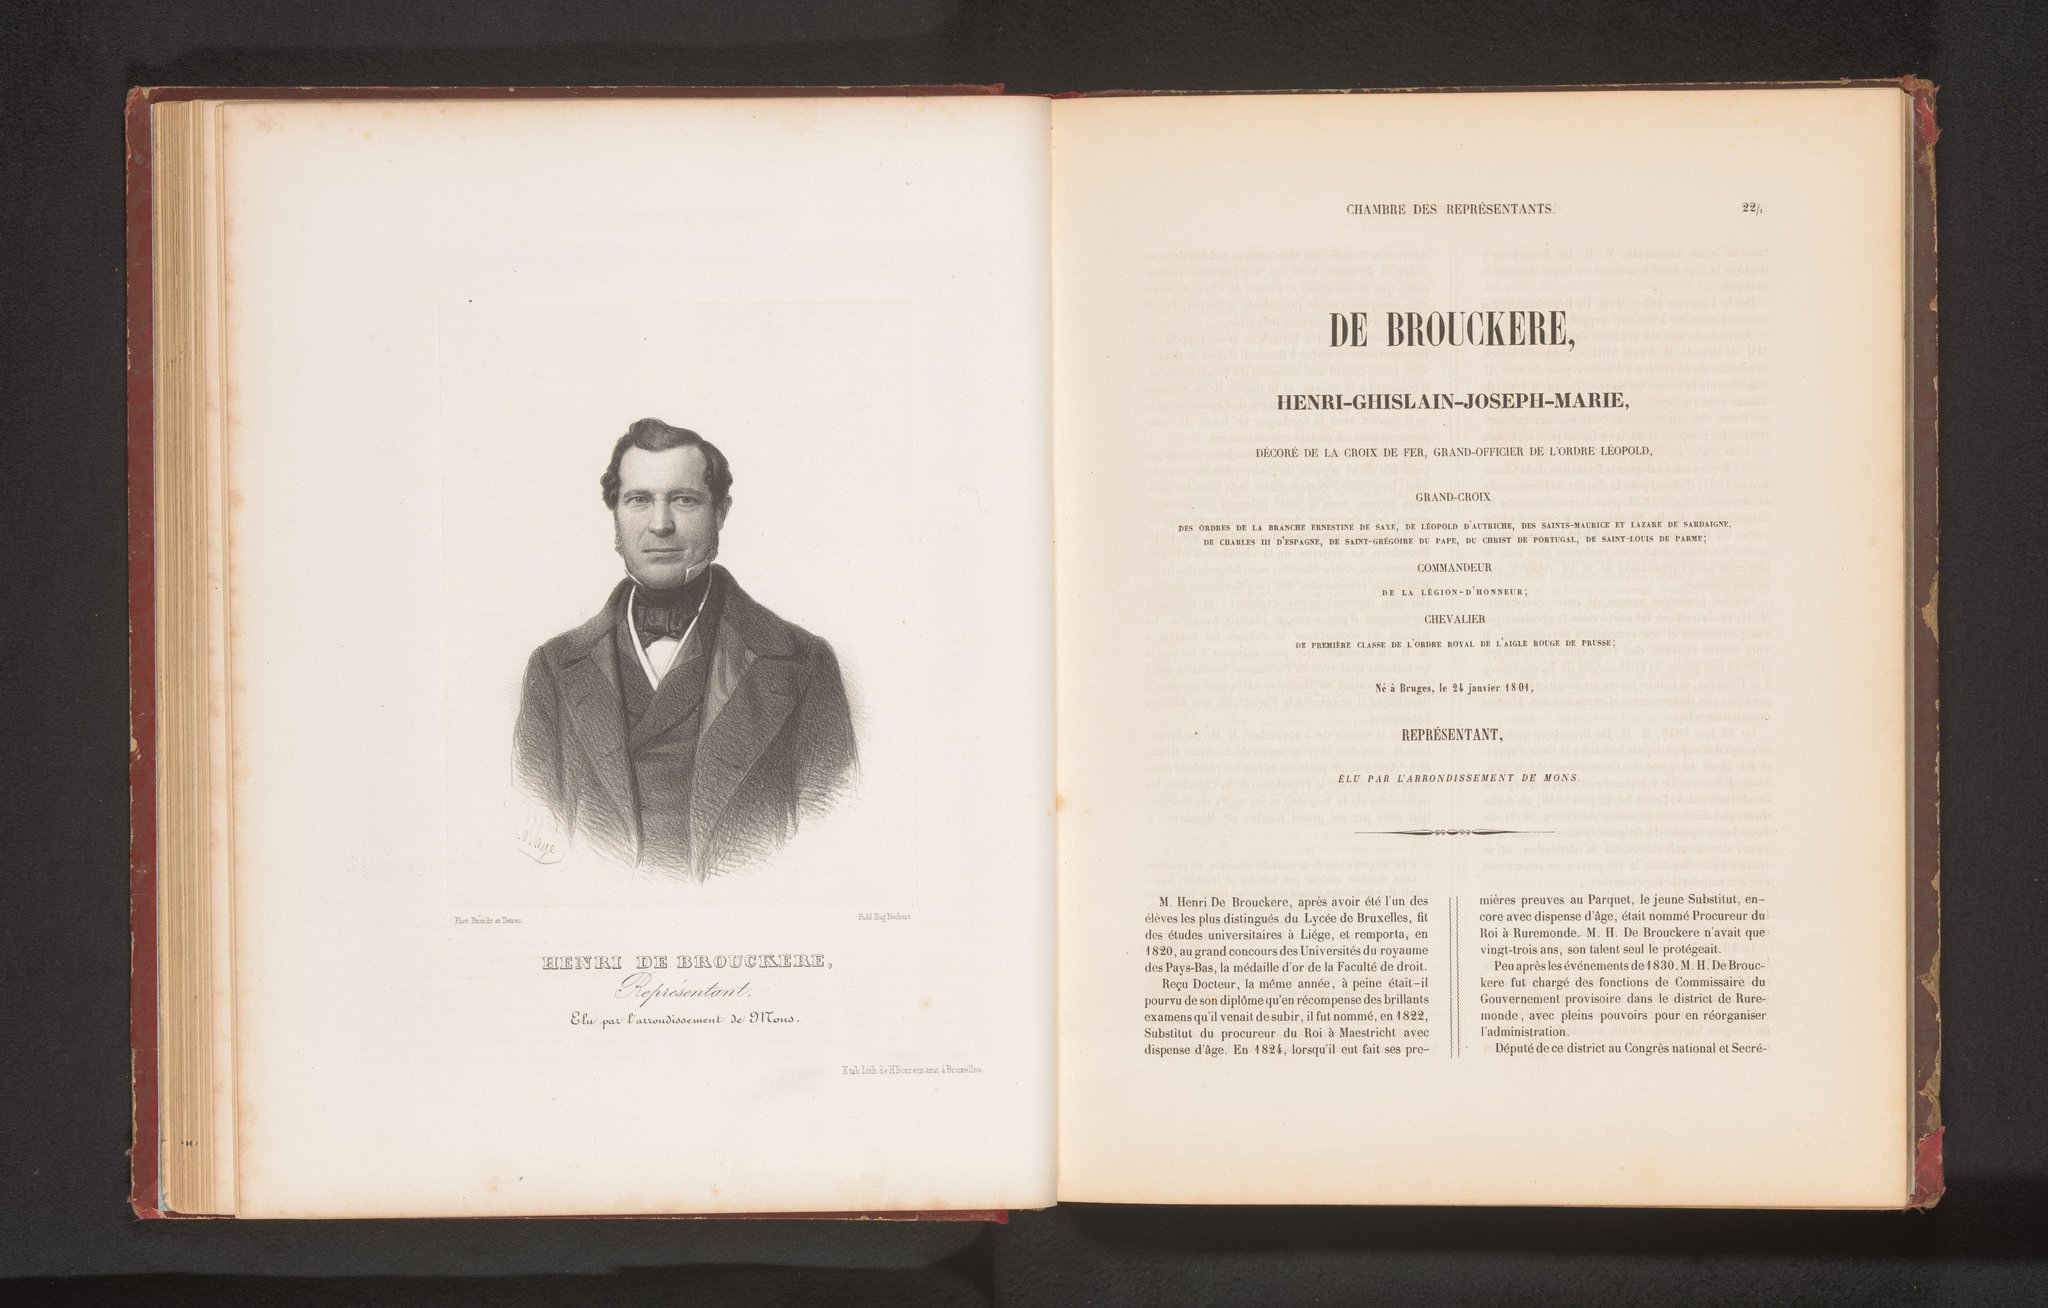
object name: print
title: Reproductie van een foto van een portret van Henri de Brouckère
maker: henri borremans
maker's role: print maker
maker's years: 1800-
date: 1853-1858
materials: paper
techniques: lithograph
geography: brussels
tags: brussels, politician, historical persons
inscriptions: inscription: ‘Représentant,/ Elu par l'arrondissement de Mons.’